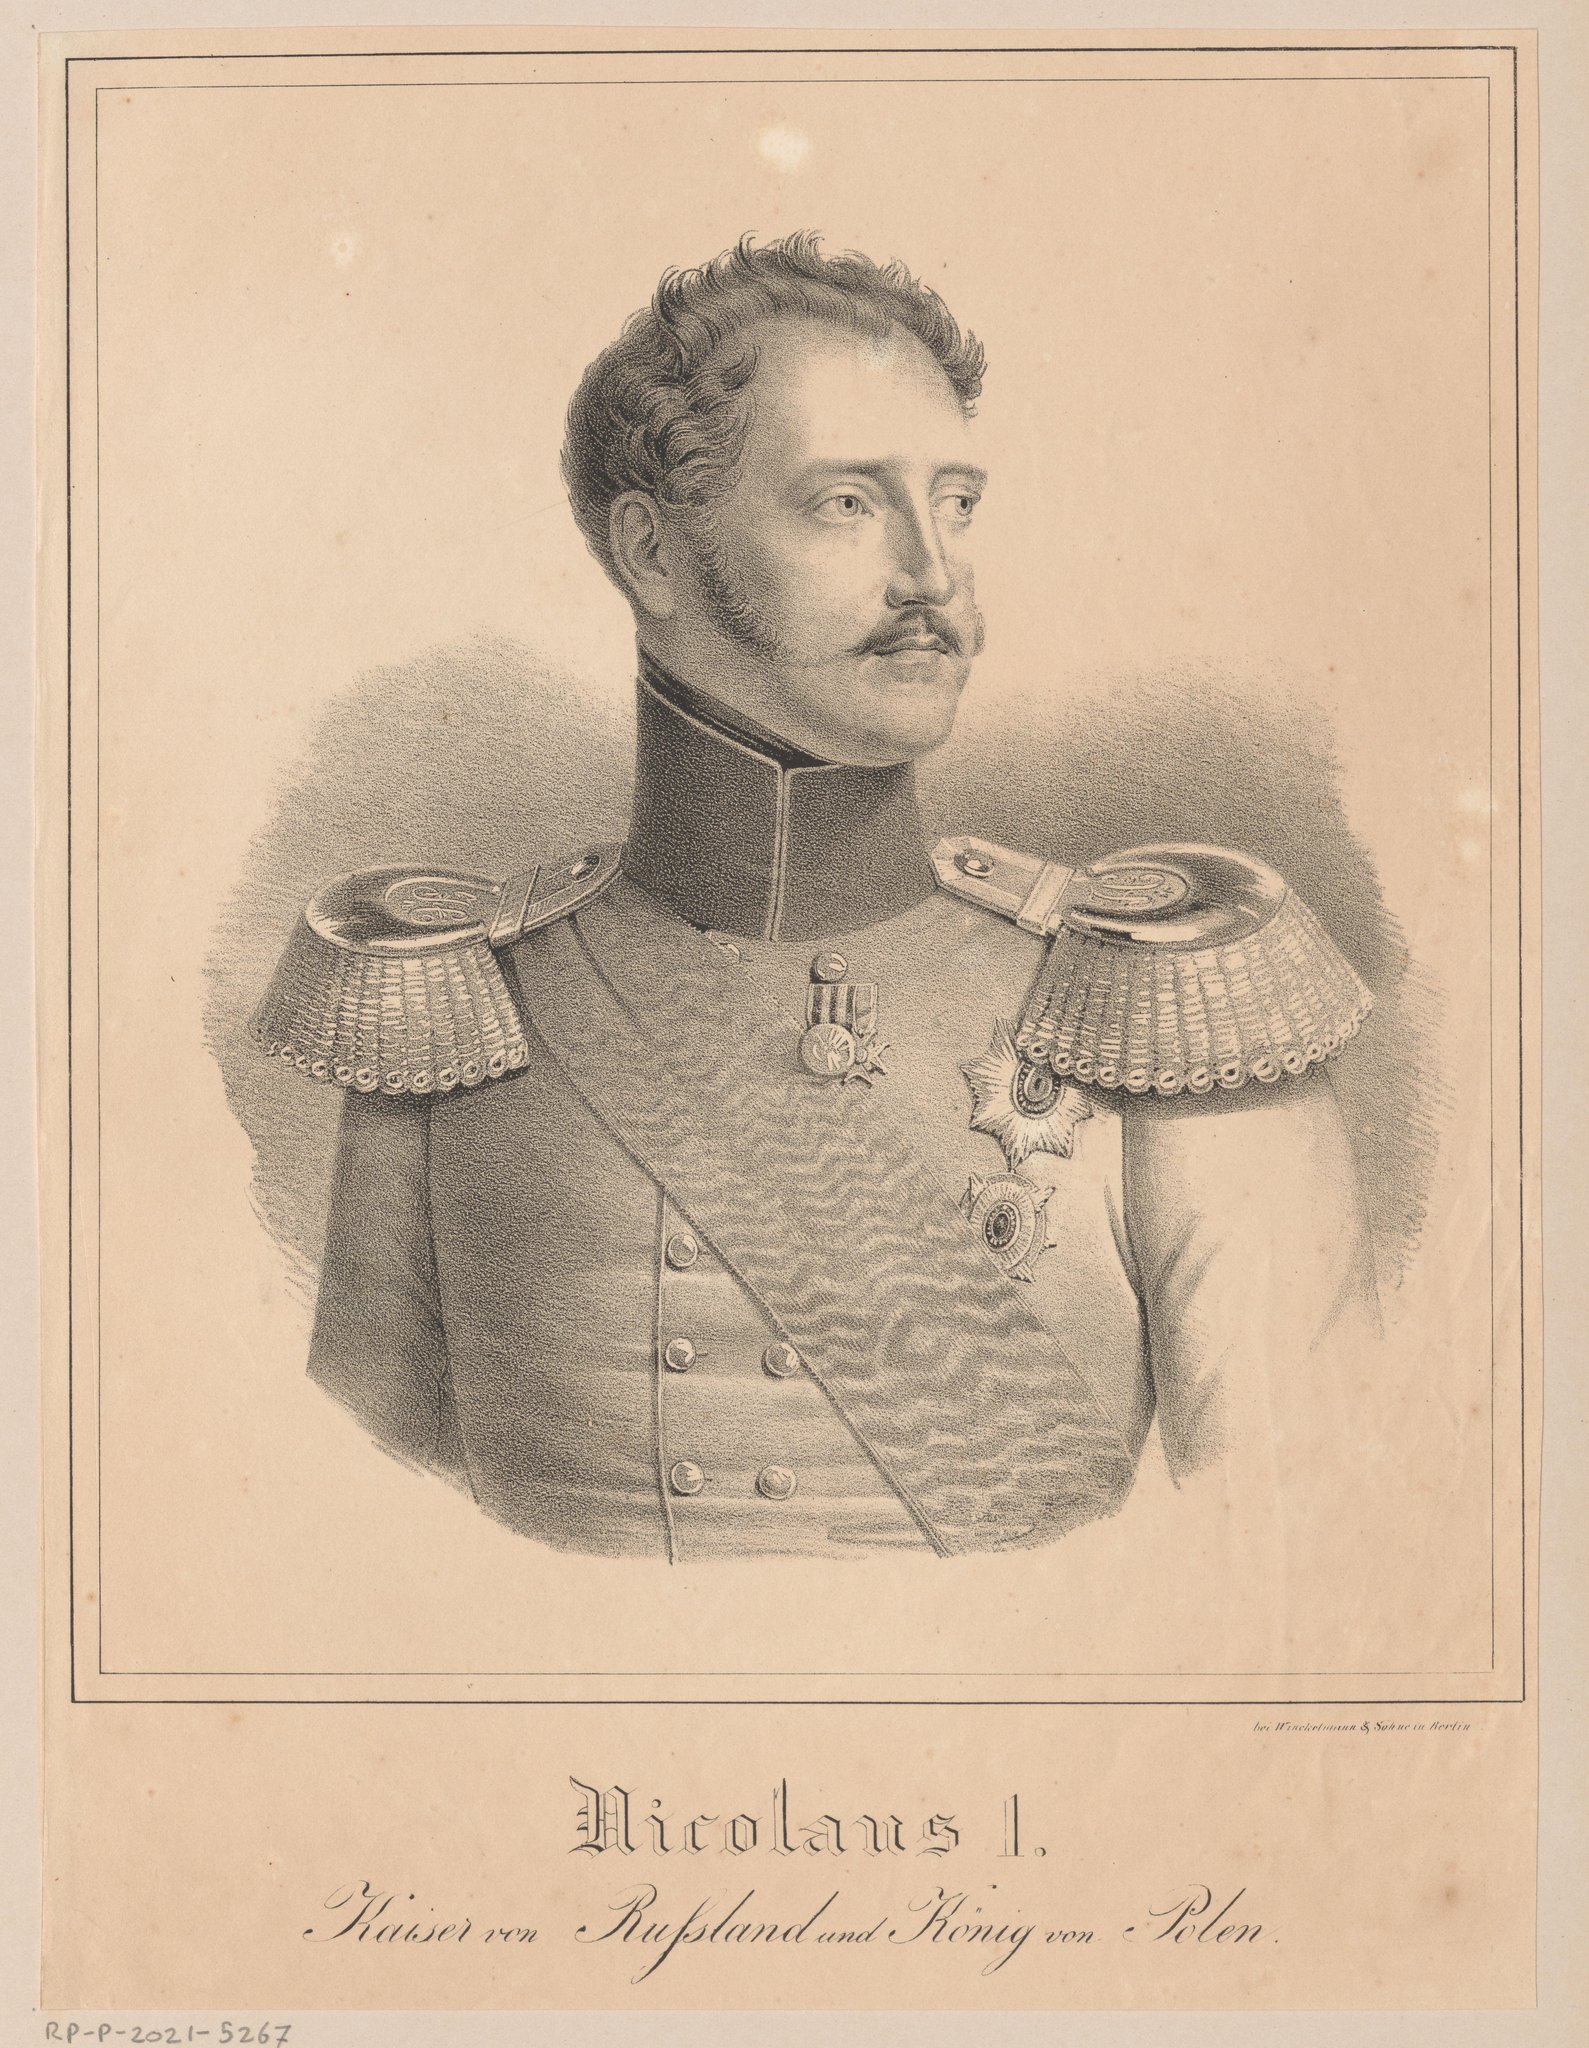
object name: print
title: Portret van Nicolaas I Pavlovitsj, tsaar van Rusland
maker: Anonymous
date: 1825-1831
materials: paper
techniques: lithograph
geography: berlin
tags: historical persons, emperor